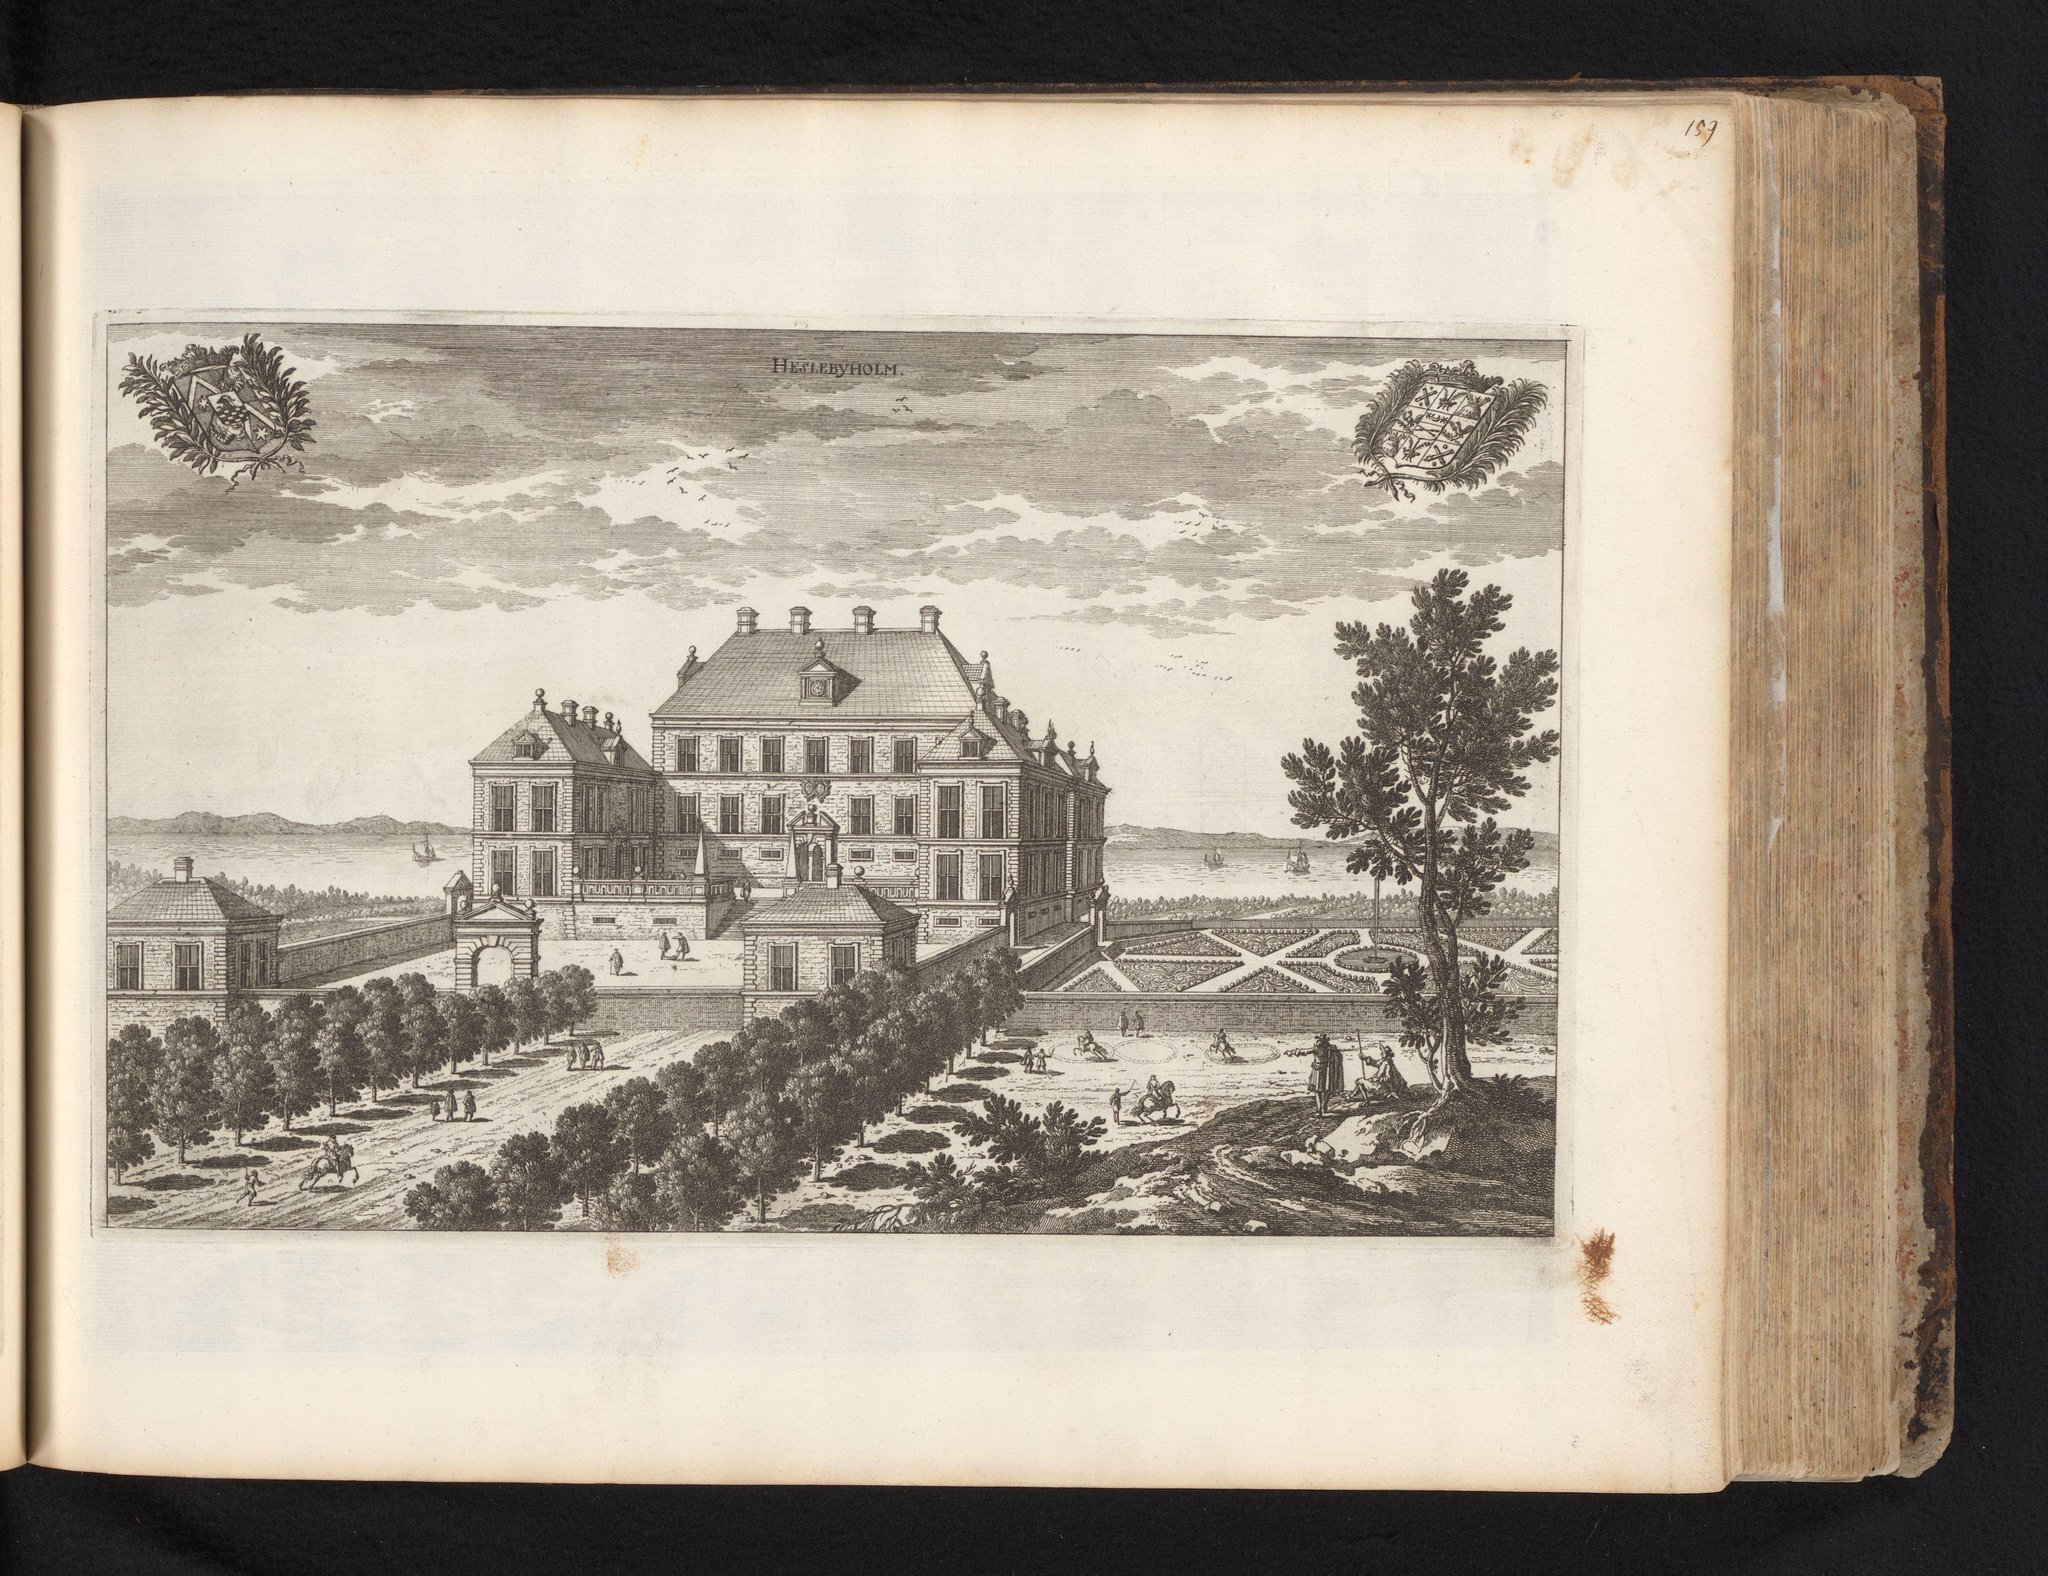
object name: album leaf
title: Gezicht op slot Hässelbyholm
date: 1670-1674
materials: paper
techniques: etching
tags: housing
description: Kungliga Biblioteket, 'Suecia': http://www.kb.se/samlingarna/Kartor-bilder/Suecia-antiqua/ (geraadpleegd november 2016).